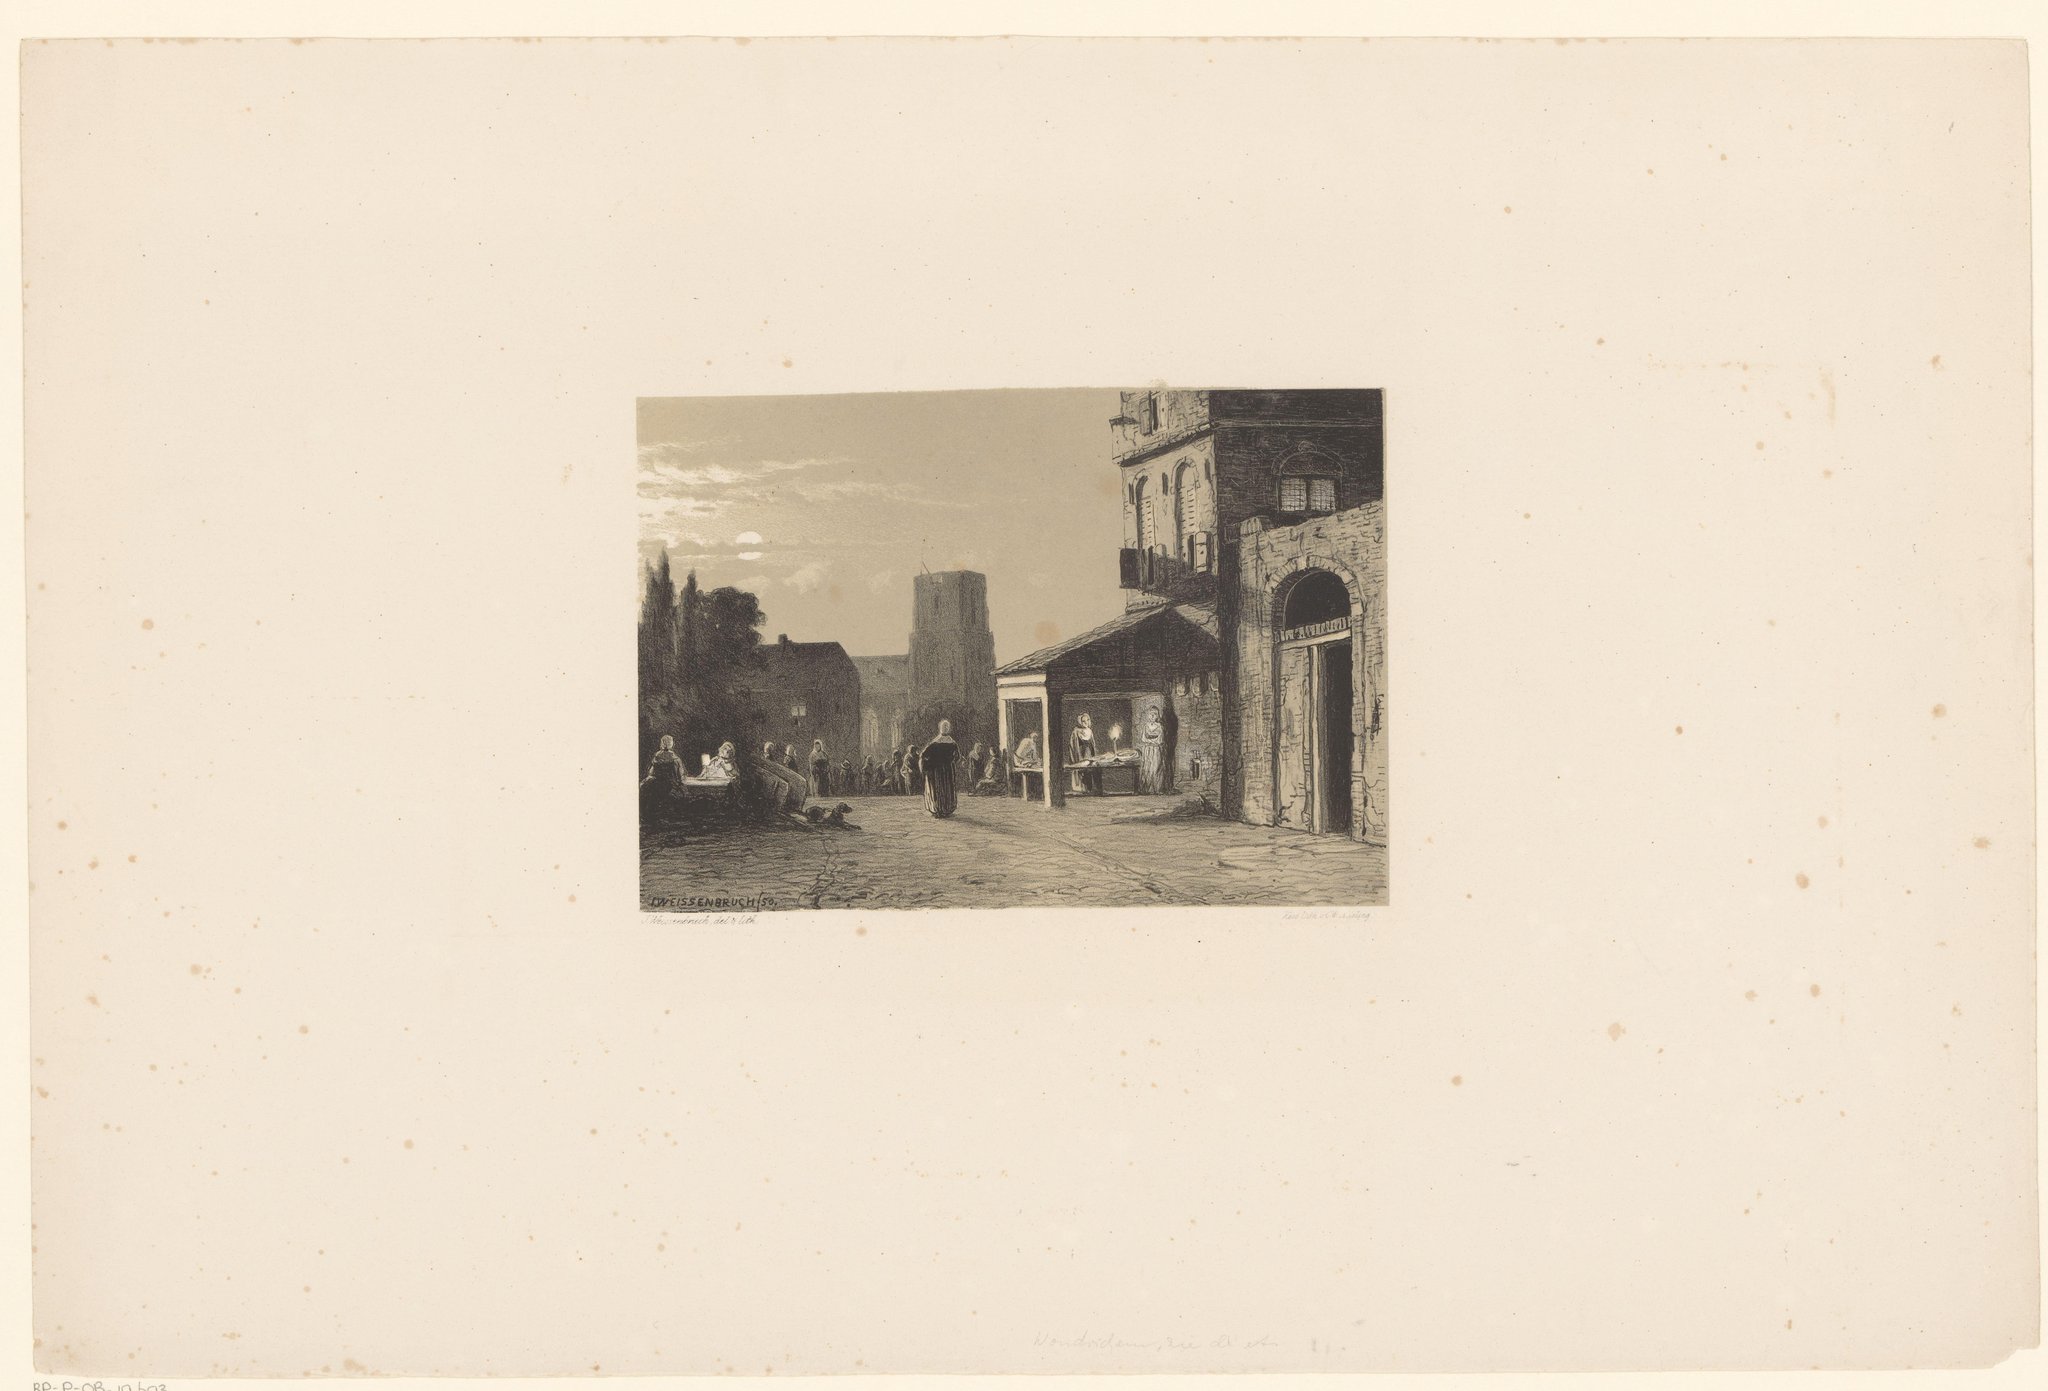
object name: print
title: Stadsgezicht bij maanlicht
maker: jan weissenbruch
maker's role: painter, print maker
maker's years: 1822-1880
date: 1850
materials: paper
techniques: tone lithography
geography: the hague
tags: city-view in general; 'veduta', moonlight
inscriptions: collector's mark: Lugt 2228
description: Een stad bij maanlicht met in de achtergrond een stompe toren. Rechts staan twee vrouwen onder een afdak bij een brandende kaars.